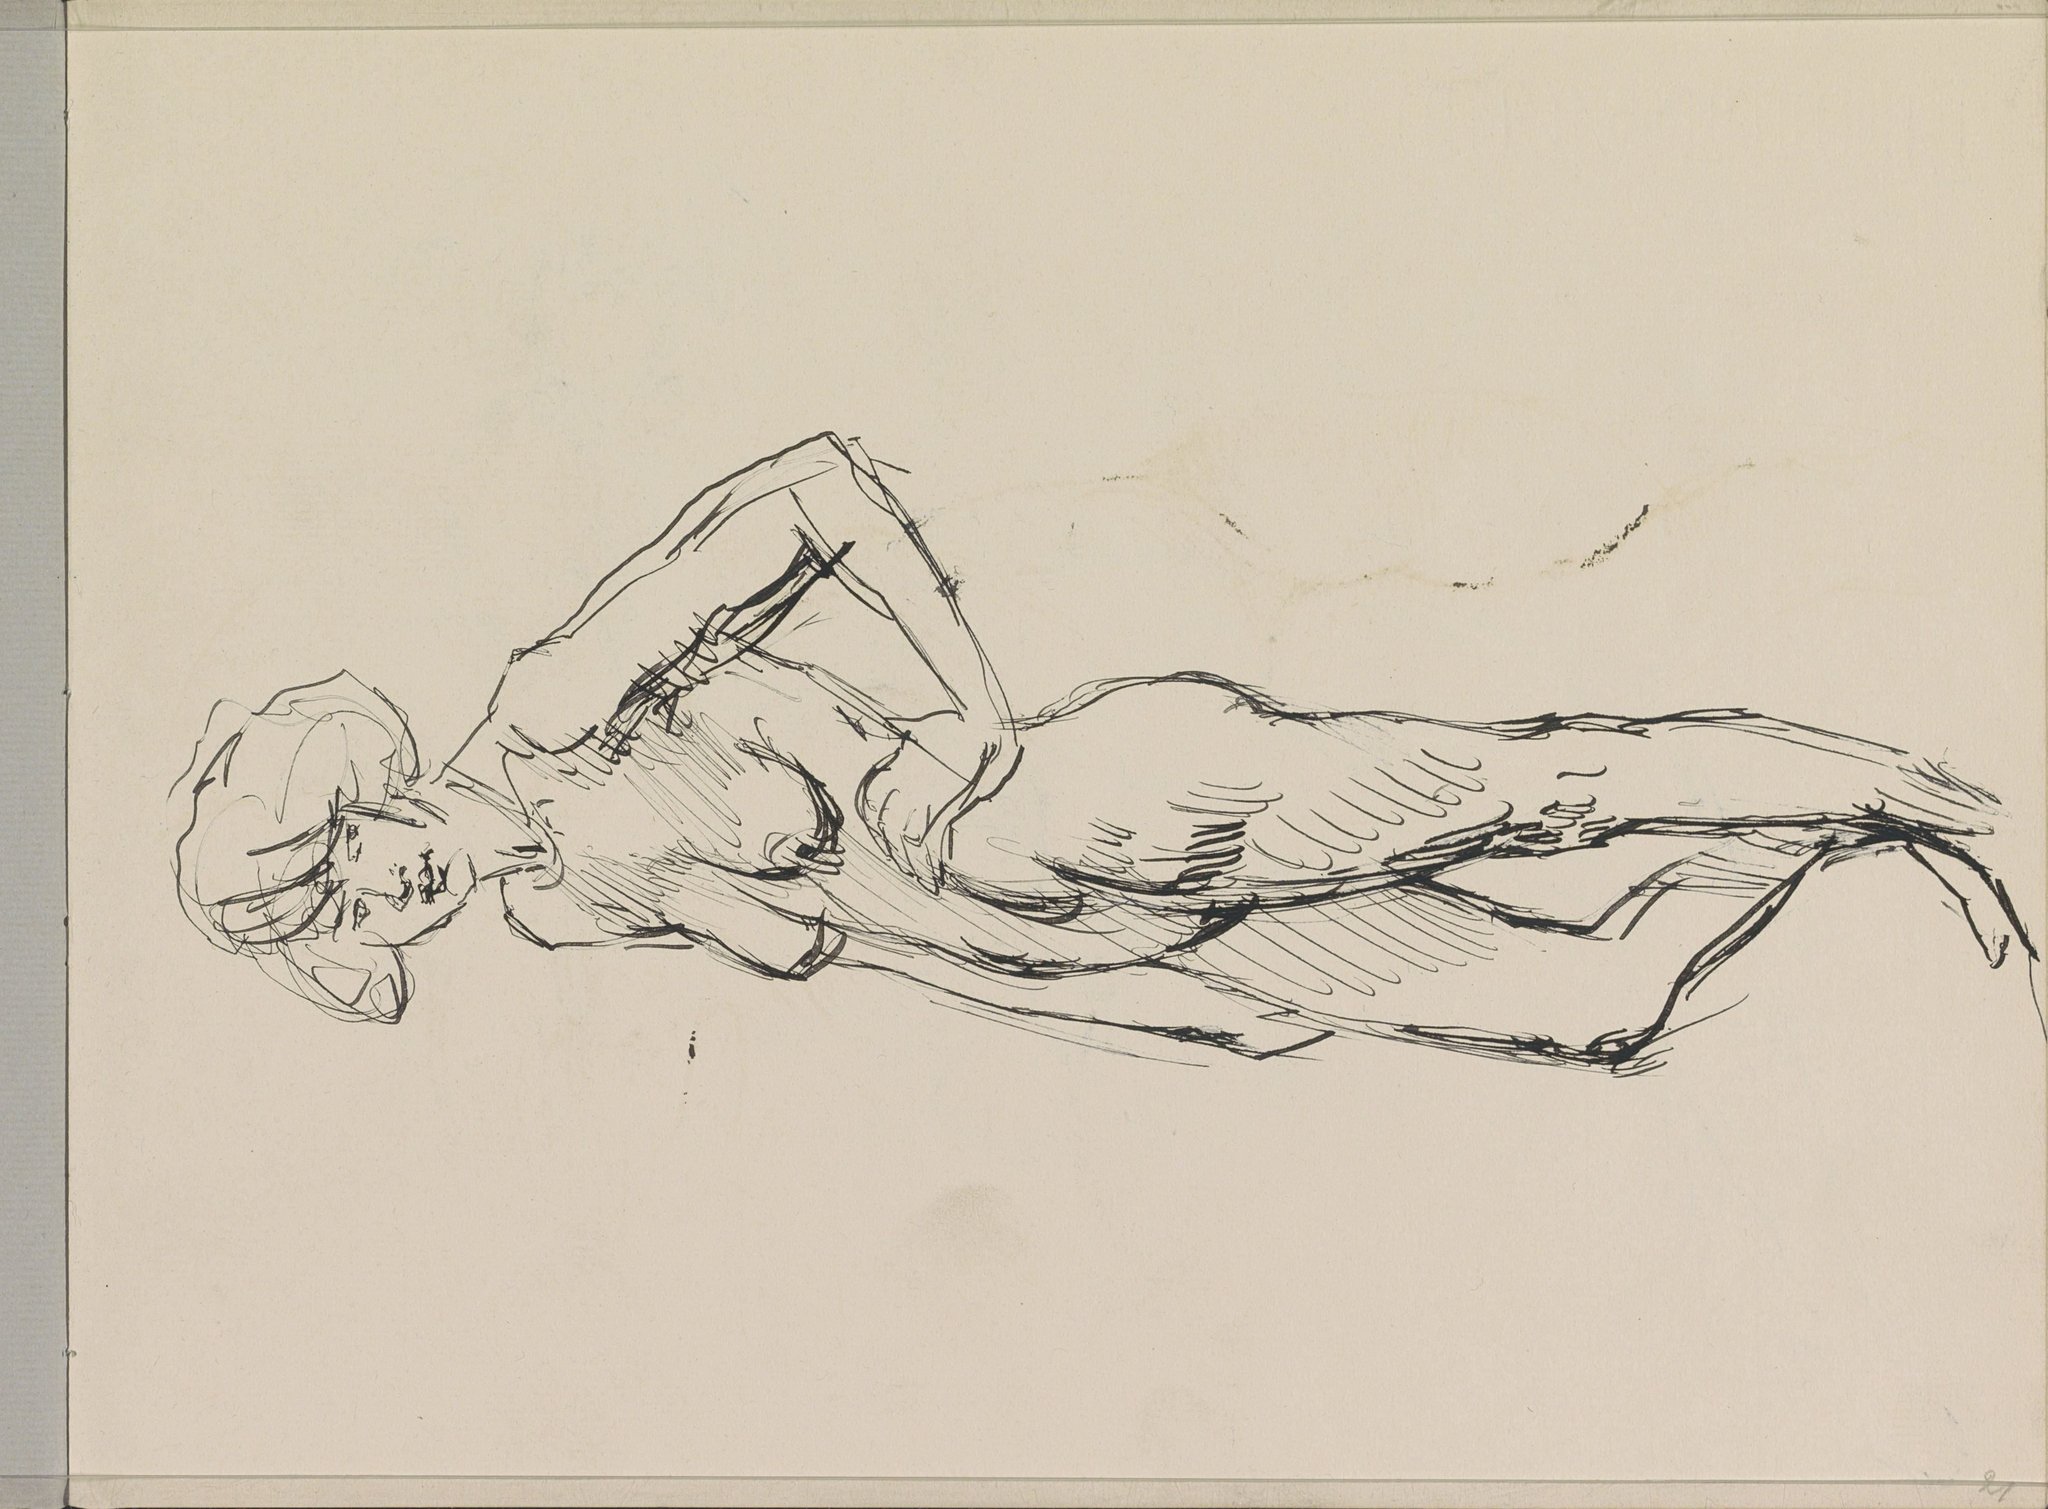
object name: sketchbook leaf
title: Standing Female Nude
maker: isaac israels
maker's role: draughtsman, painter, print maker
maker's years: 1865-1934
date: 1875-1934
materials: ink, paper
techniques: pen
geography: the hague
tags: 'contrapposto', 'standbein und spielbein' - aa - female human figure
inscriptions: watermark: ‘Holland’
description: Blad 21 recto uit schetsboek IV met 27 bladen.